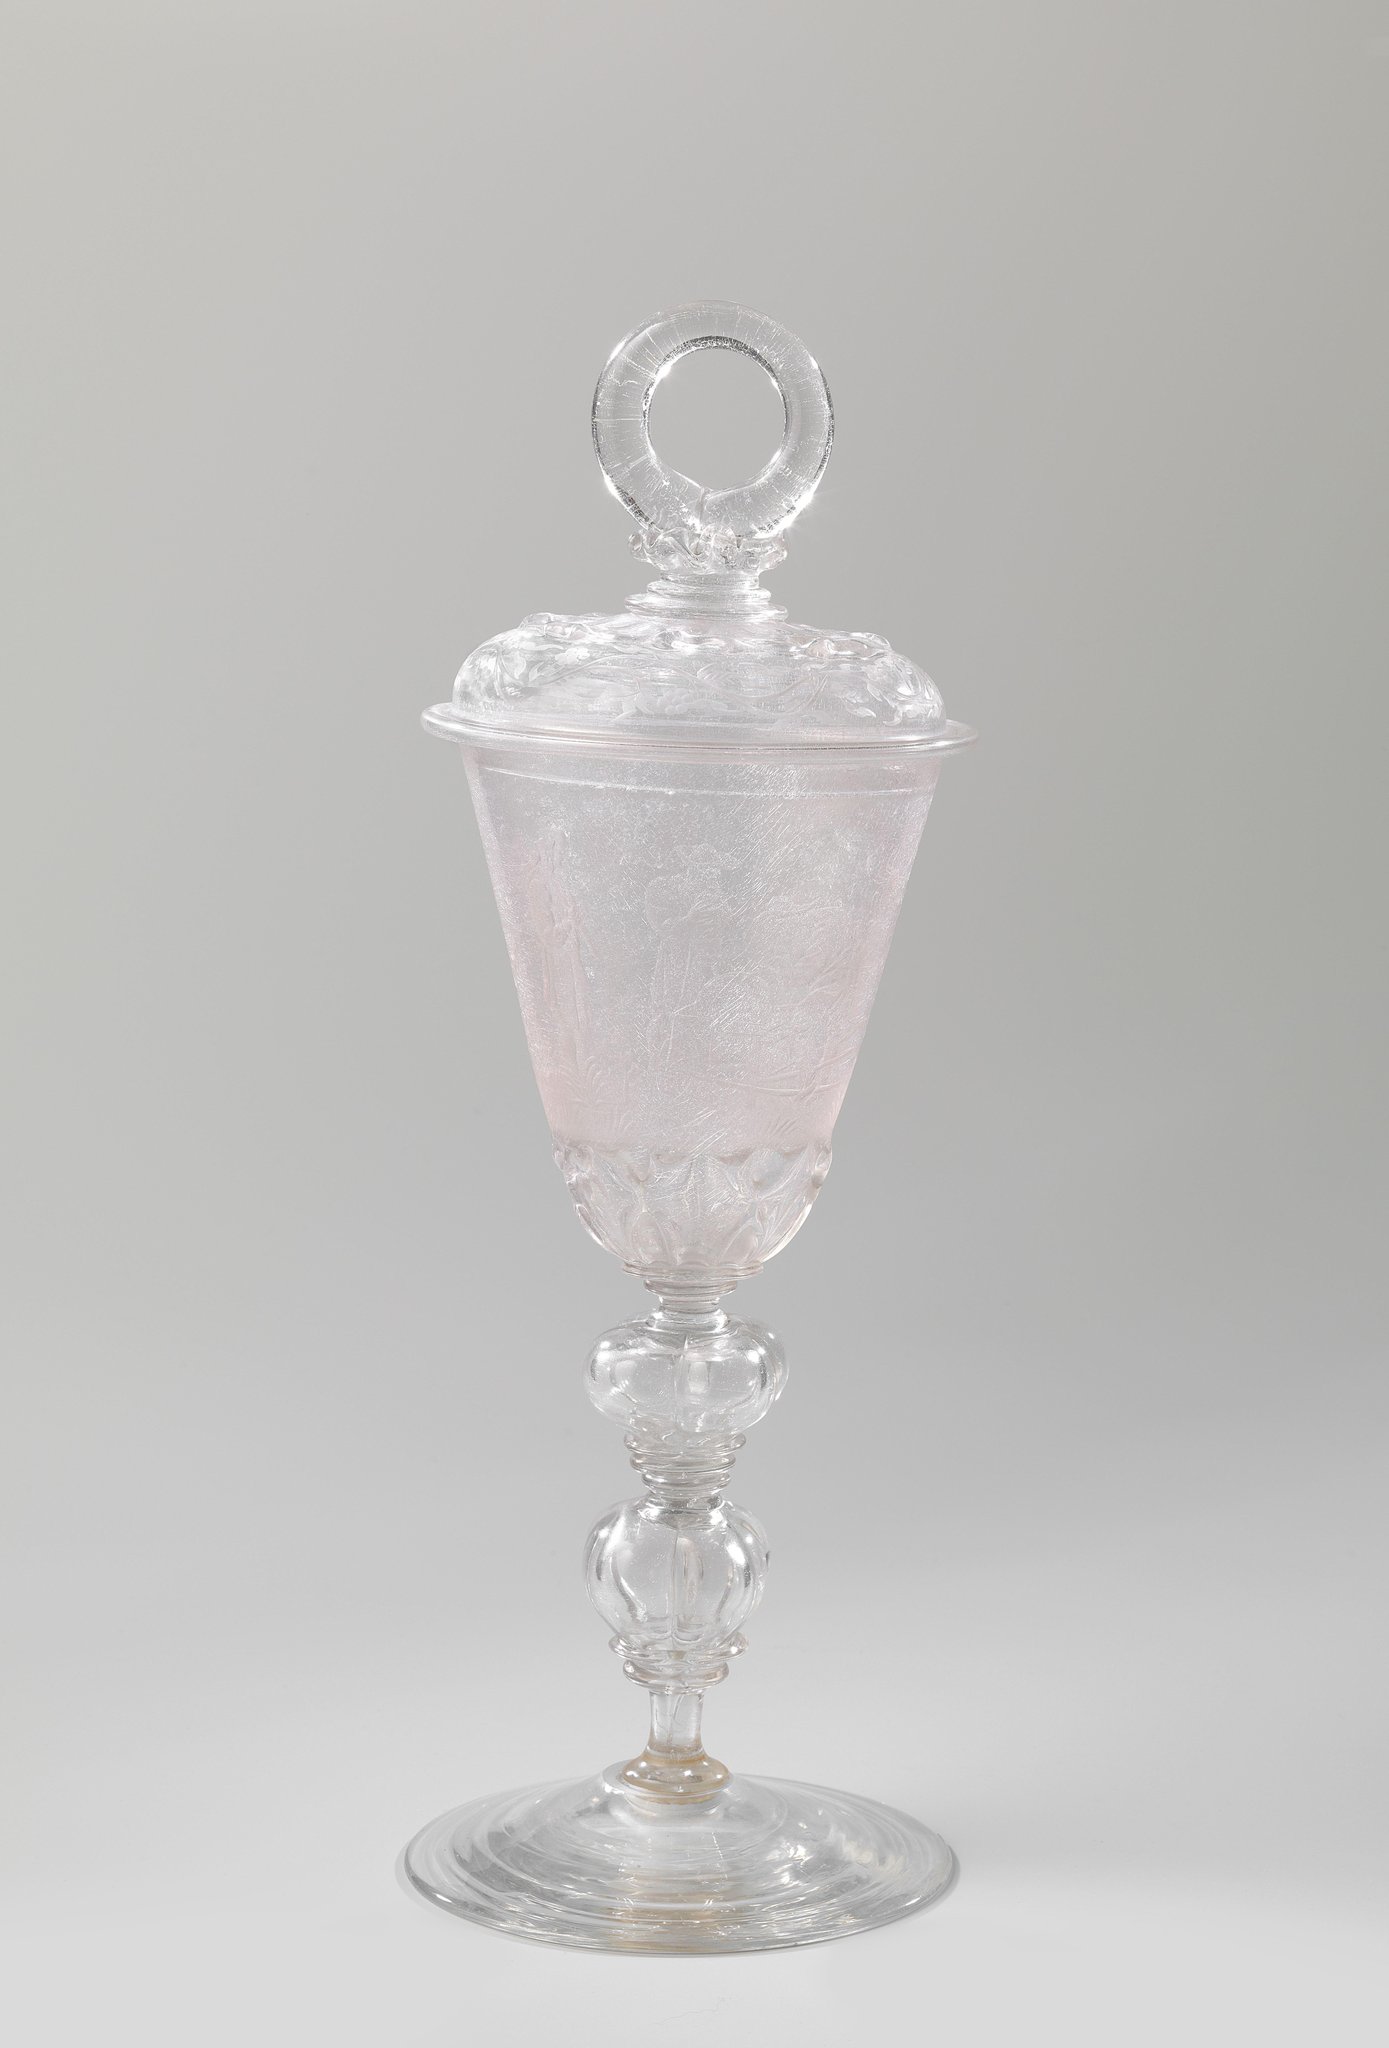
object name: lid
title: Bokaal met een scharensliep, een houtvester en een jongen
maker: Anonymous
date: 1680-1700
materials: glass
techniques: façon de venise, glassblowing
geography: northern netherlands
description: Gewelfde voet met omgeslagen rand. Stam met een holle, geribde knop en een holle, vierlobbige knop; beide tussen schijven. Conische kelk met afgeronde bodem. Op de kelk een scharensliep, een houtvester en een jongen. Deksel met knop in vorm van een ring.